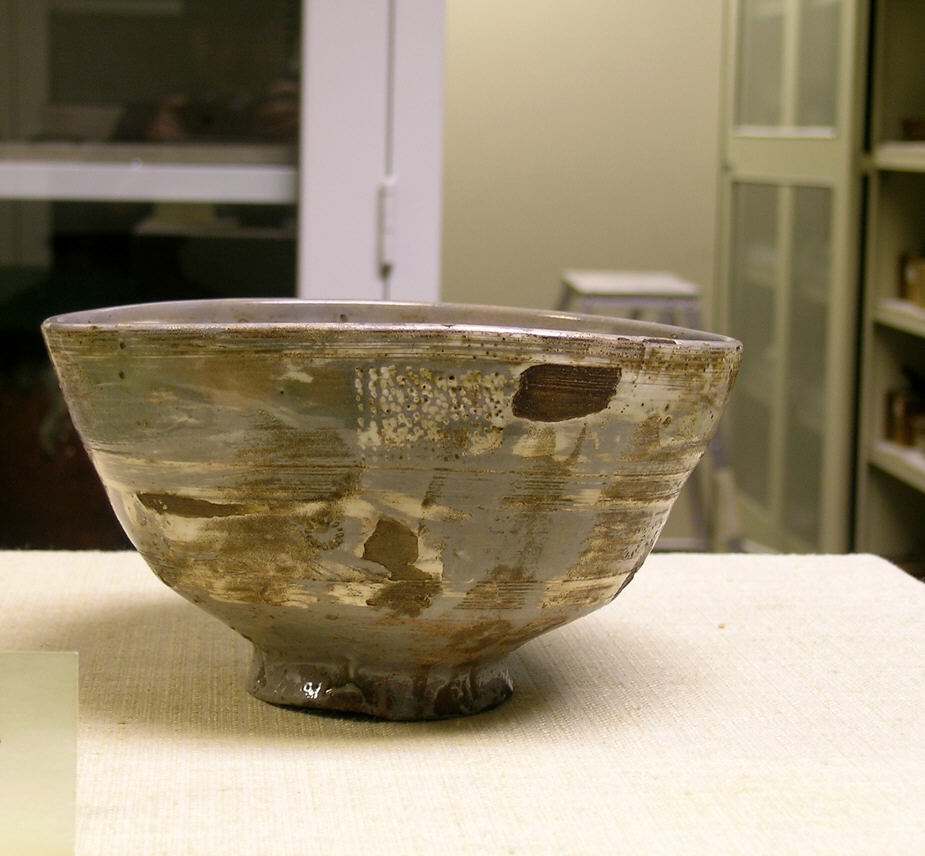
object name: bowl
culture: japanese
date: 1800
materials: clay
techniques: inlay